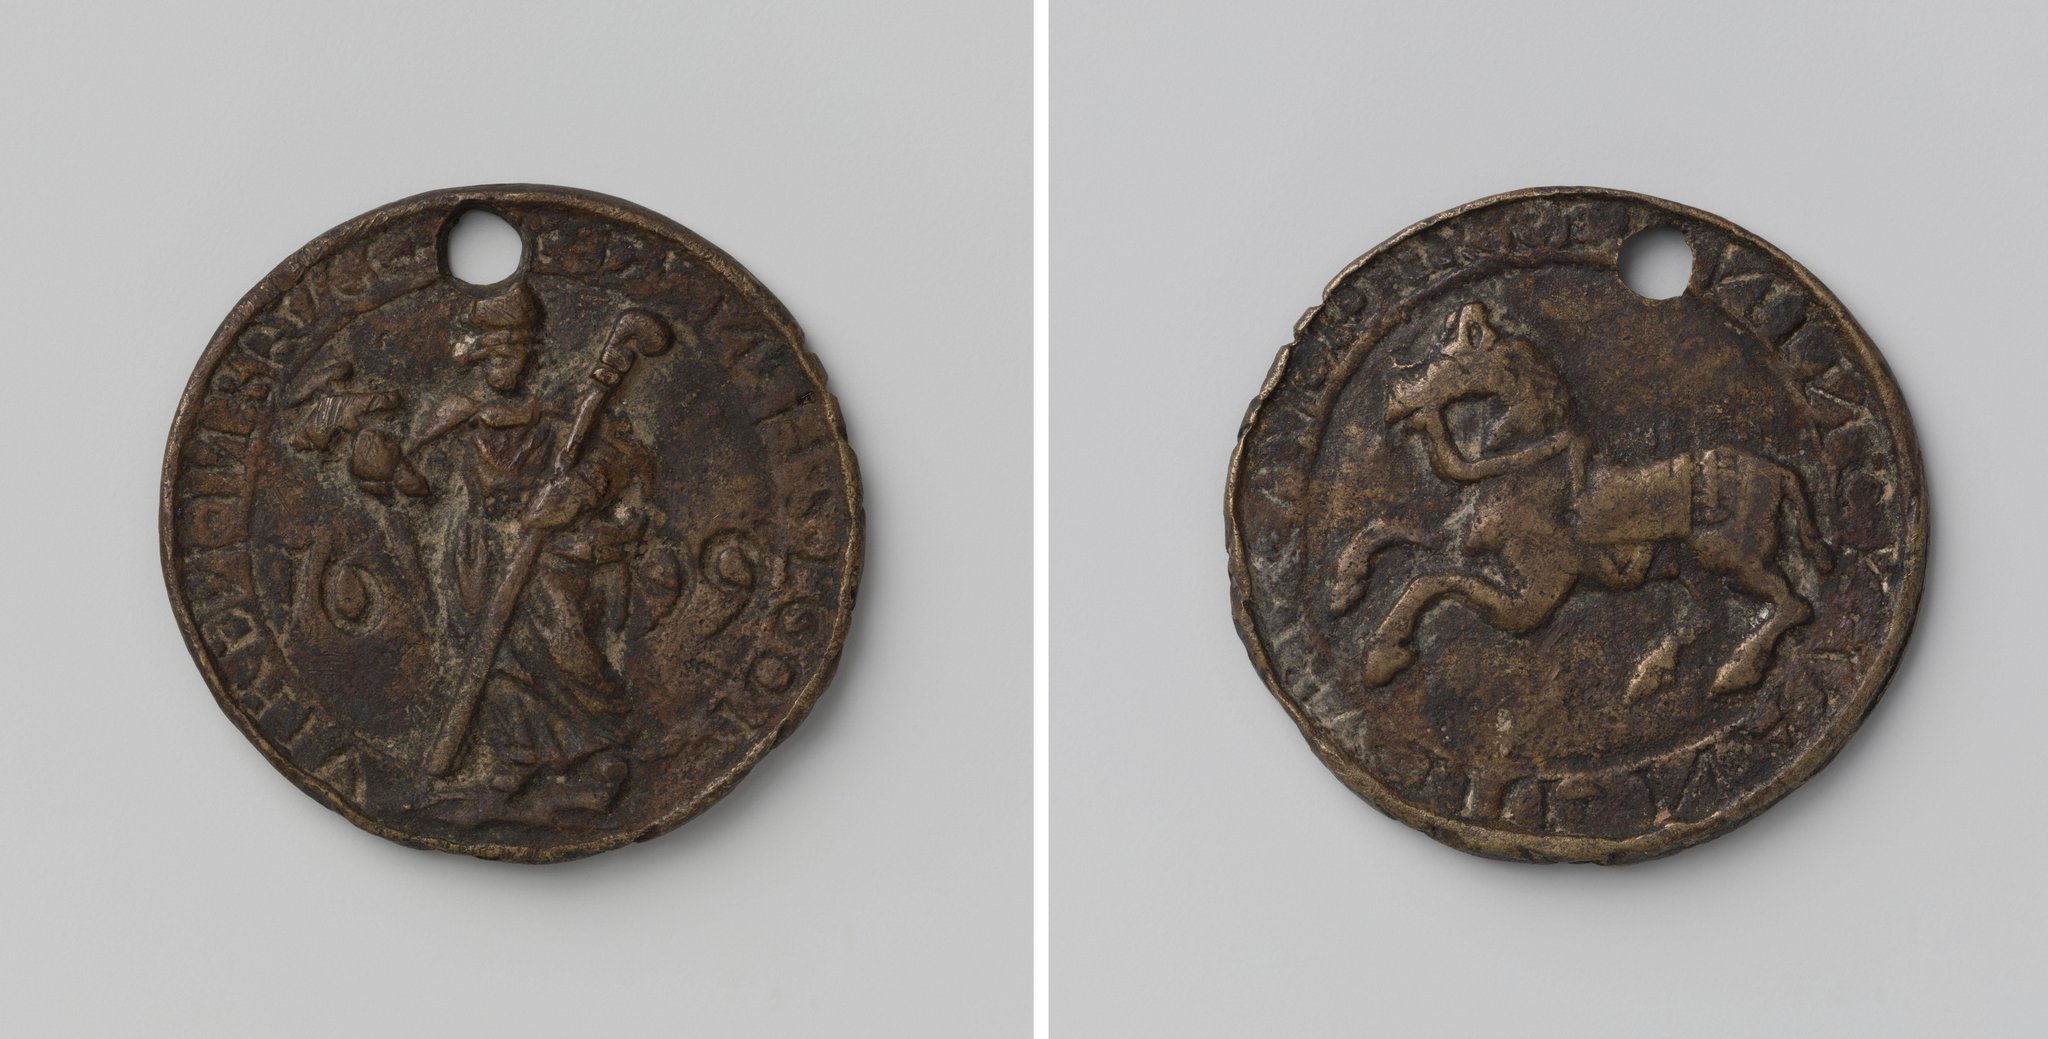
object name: medal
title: Gildepenning van het Sint Eligius- of Smedengilde te Brugge, met nummer 47.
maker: Anonymous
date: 1699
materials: brass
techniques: casting, engraving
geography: bruges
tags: goldsmith, bruges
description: Messing penning met gat erin. Voorzijde: gemijterde St. Eligius met staf in linker- en smidshamer in geheven rechterhand tussen jaartal binnen omschrift. Keerzijde: naar links rennend paard binnen omschrift; randschrift: Romeins cijfer XXXXVII